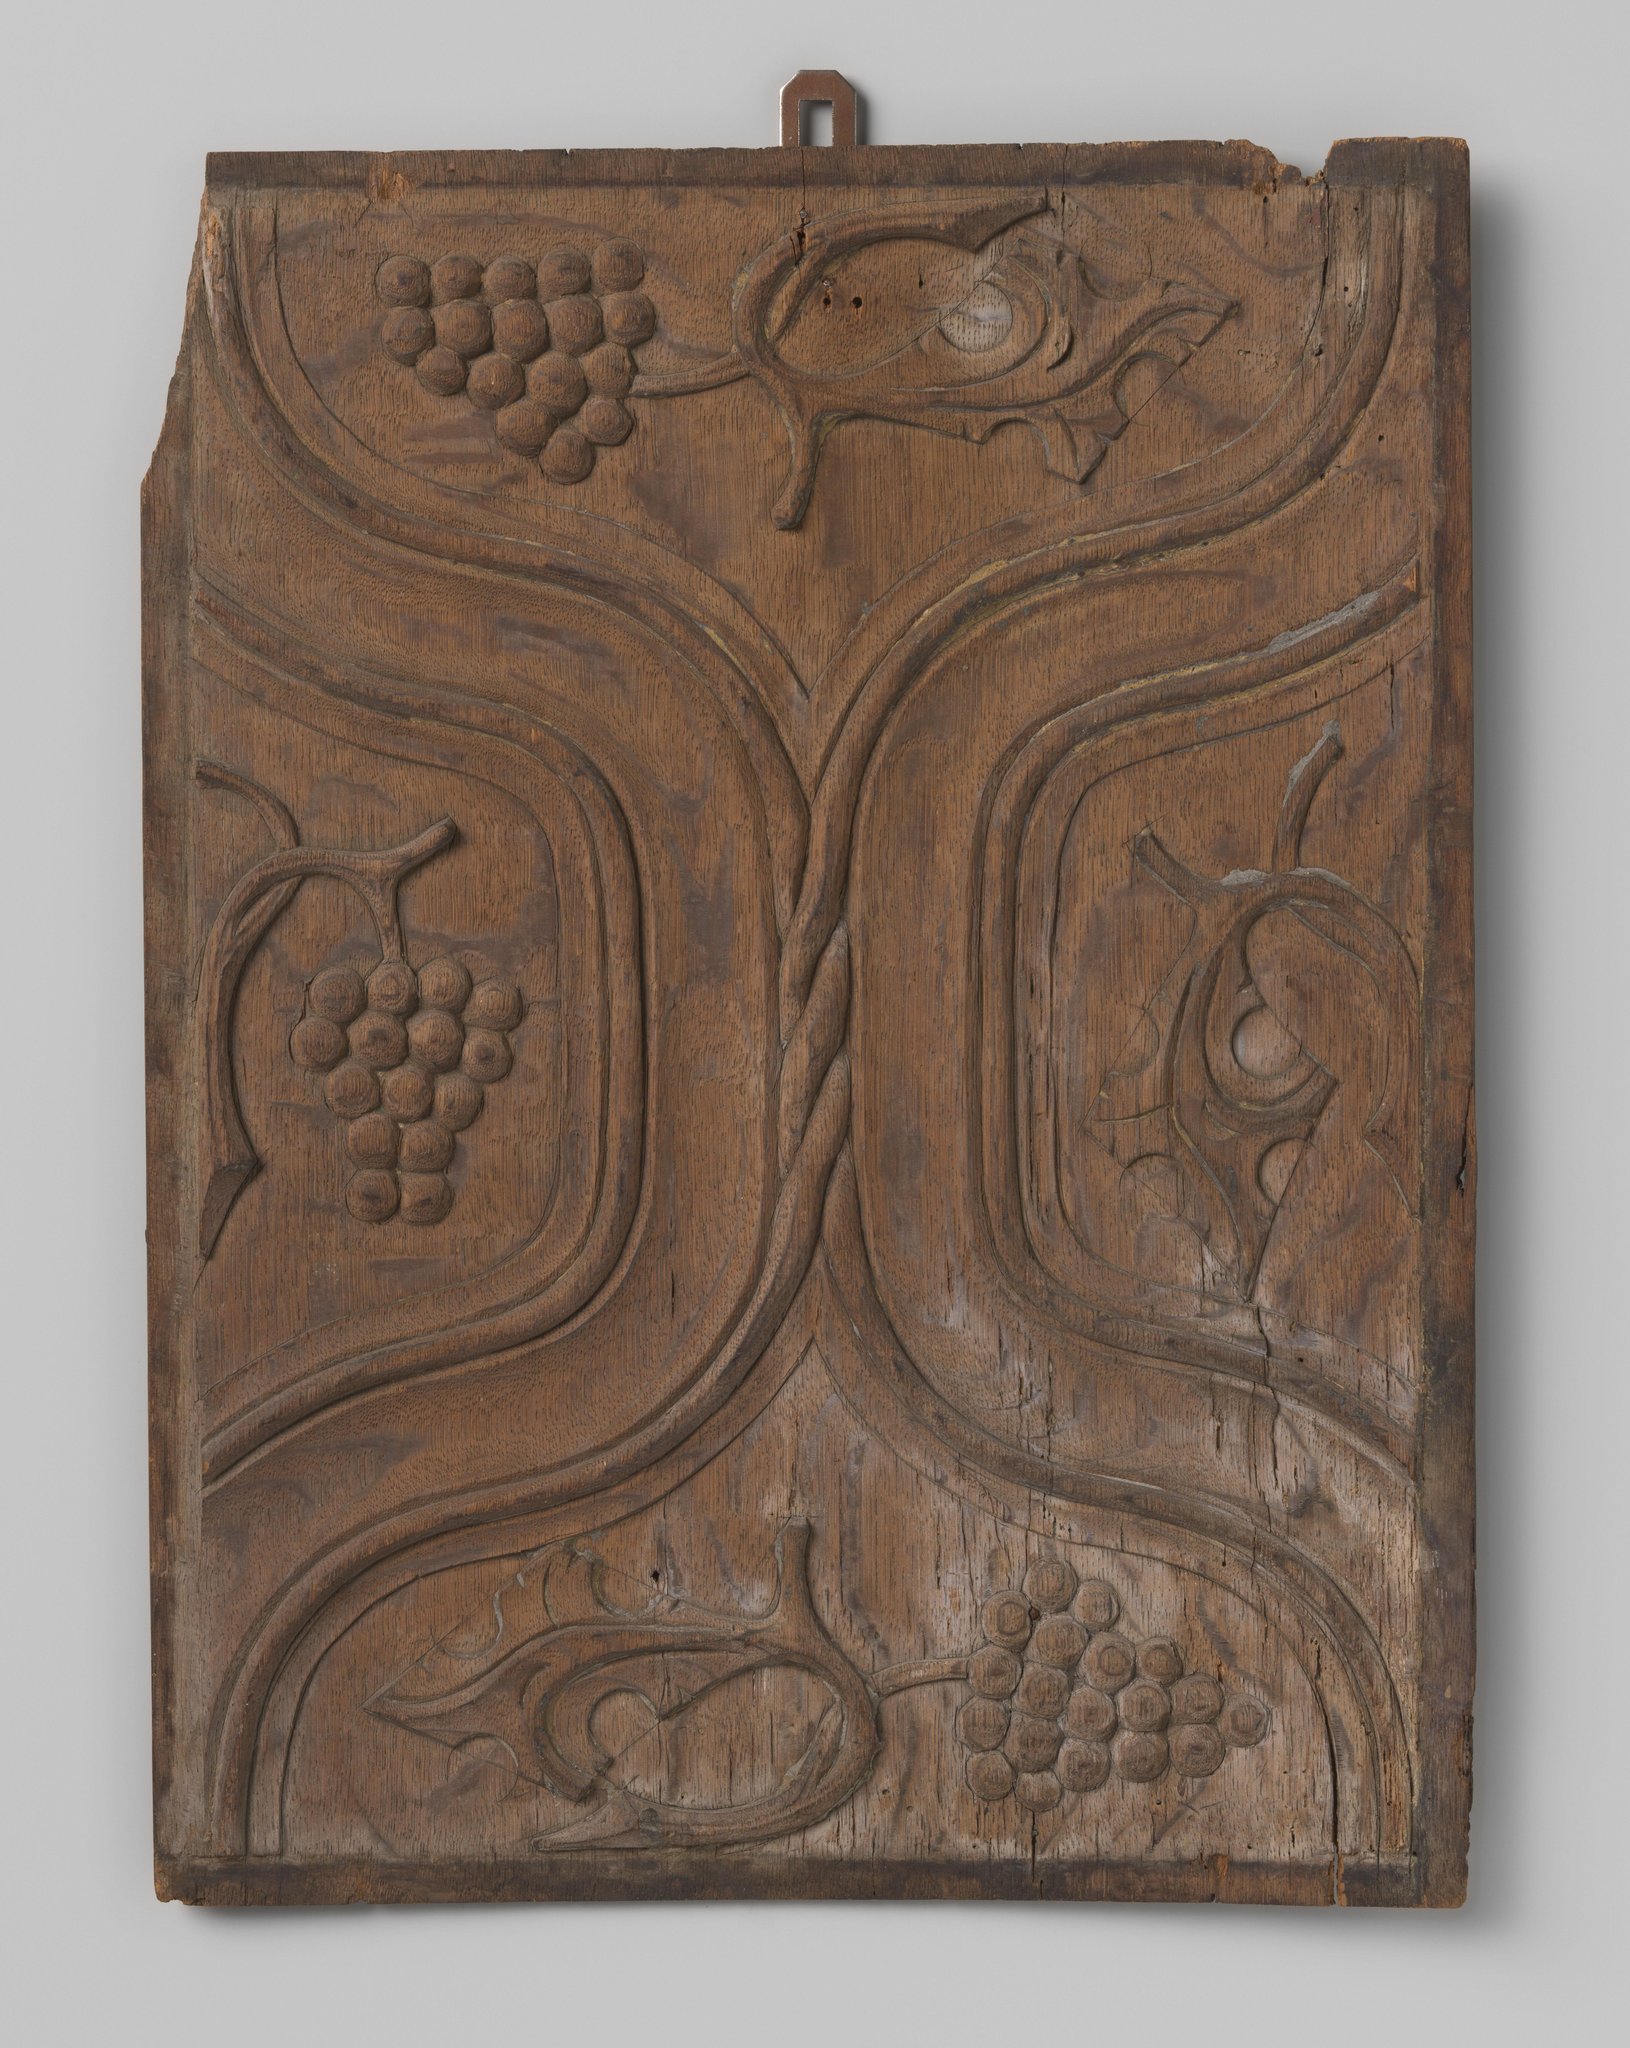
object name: interieuronderdeel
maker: Anonymous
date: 1500-1550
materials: wood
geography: netherlands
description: Paneel, versierd met de uit de "brief" ontwikkelde bladslingers, die een kabeling in het midden vertonen en wingerdtakjes met druiventrossen in de uitgrondingen hebben.